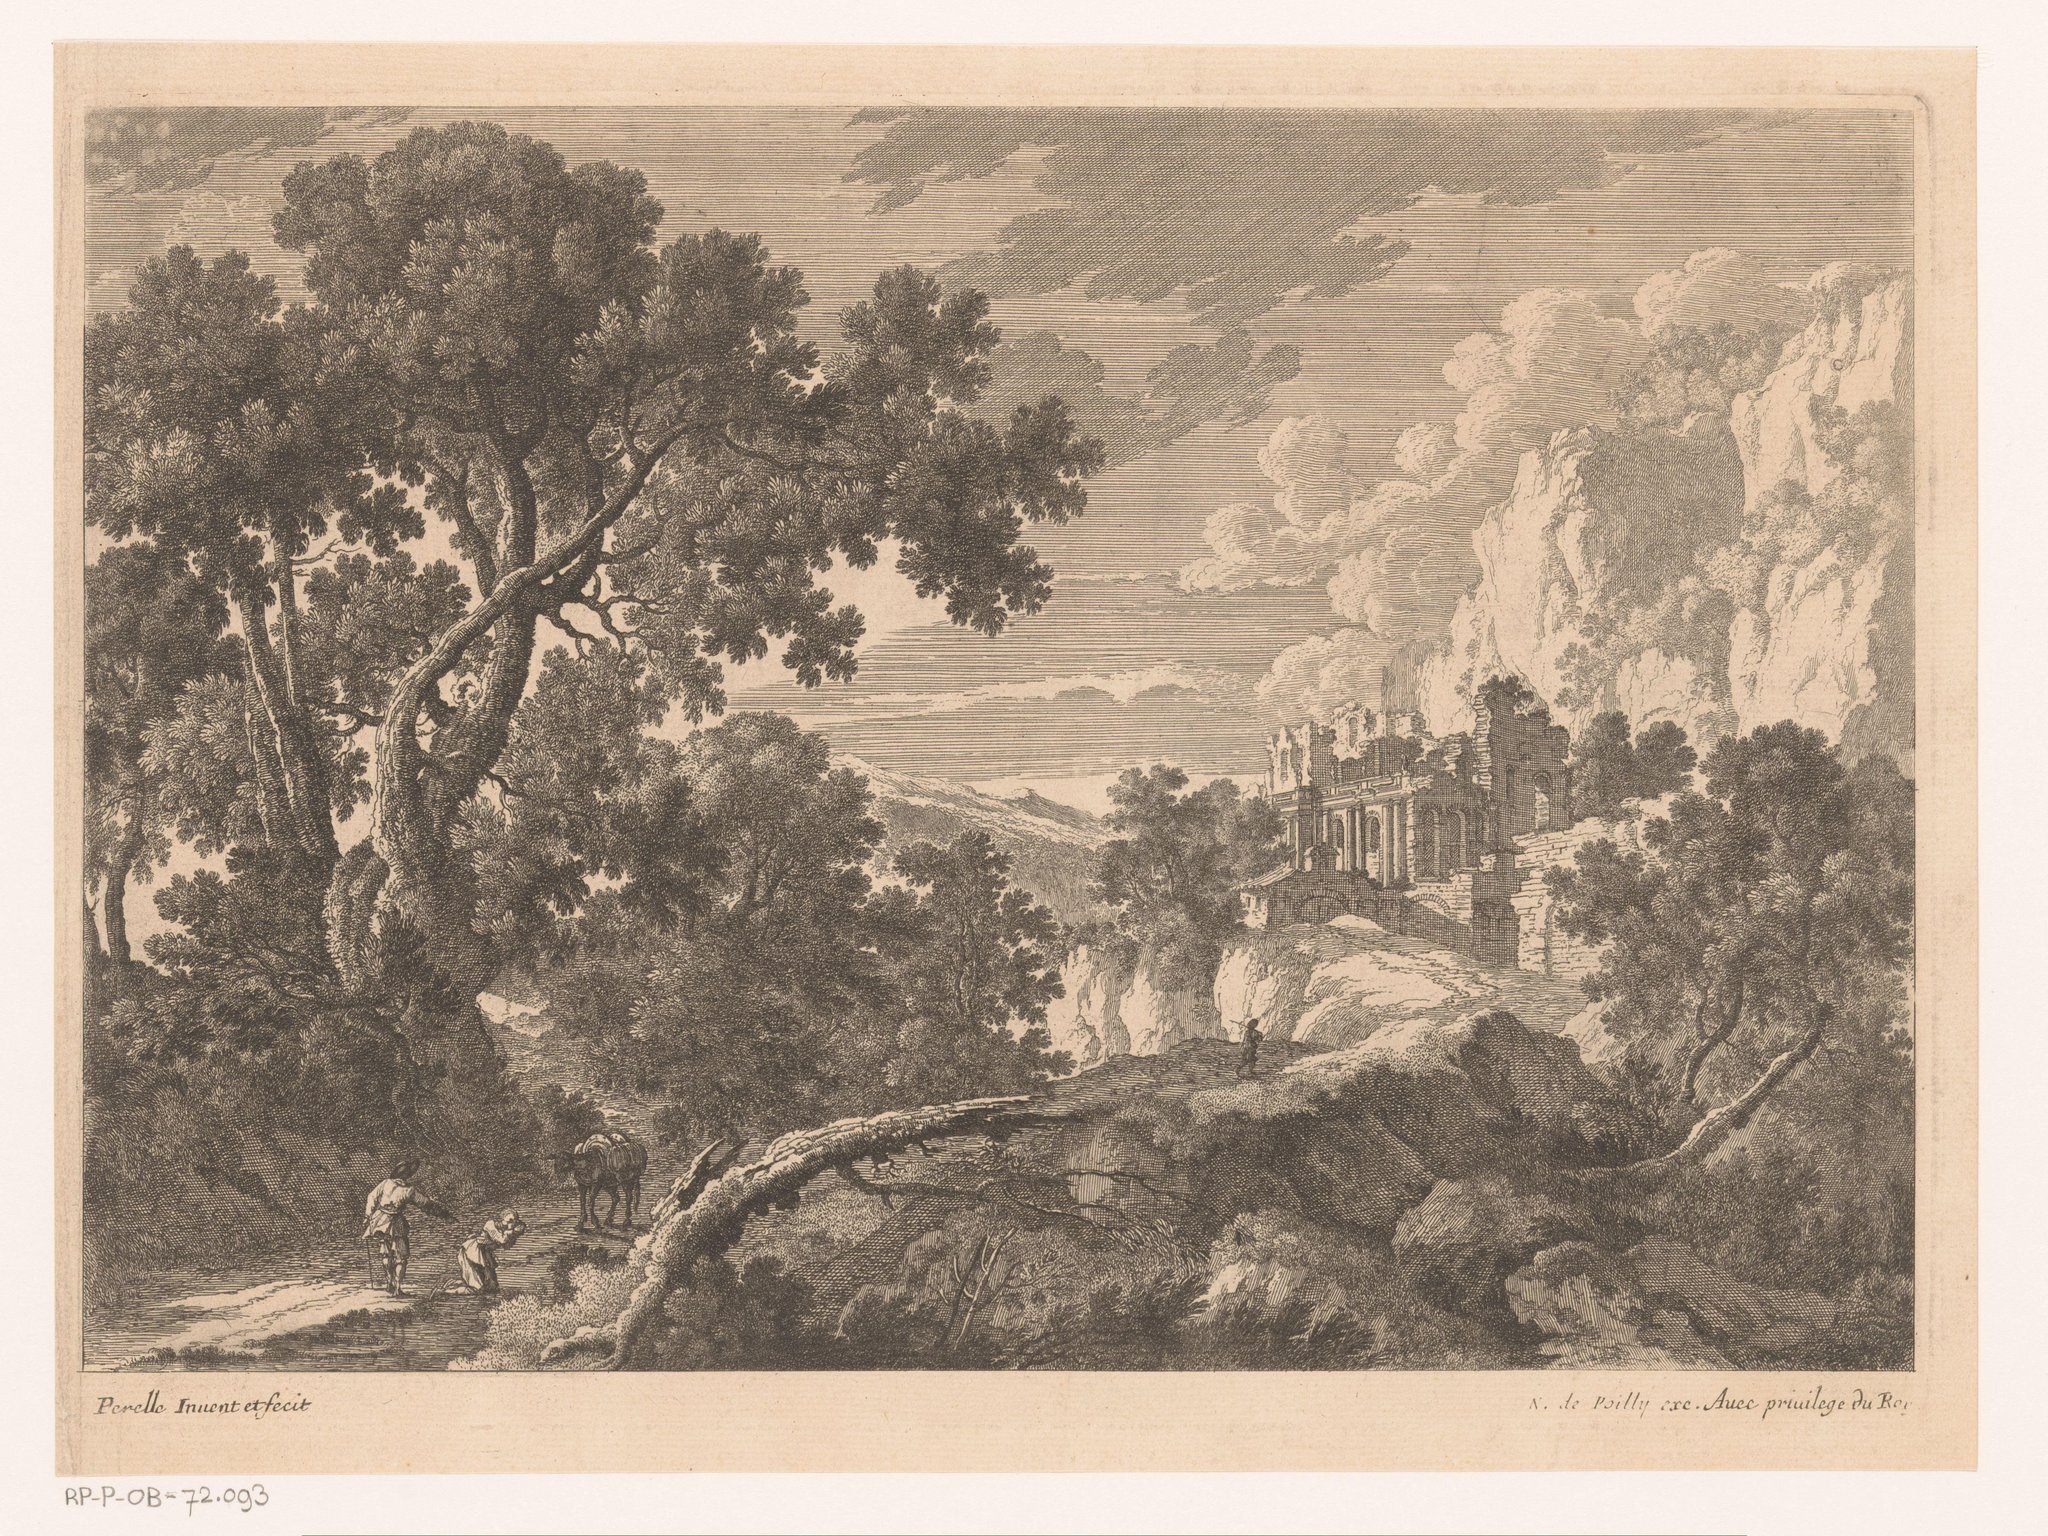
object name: print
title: Landschap met knielende figuur bij een ezel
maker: nicolas de poilly (i)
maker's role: print maker, publisher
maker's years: 1626-1696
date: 1613-1695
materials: paper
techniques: etching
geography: paris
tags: landscape with ruins, kneeling figure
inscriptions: collector's mark: Lugt 2228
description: Prenten met het signatuur 'Perelle' kunnen zowel door vader Gabriel als door zonen Nicolas en Adam gemaakt zijn.